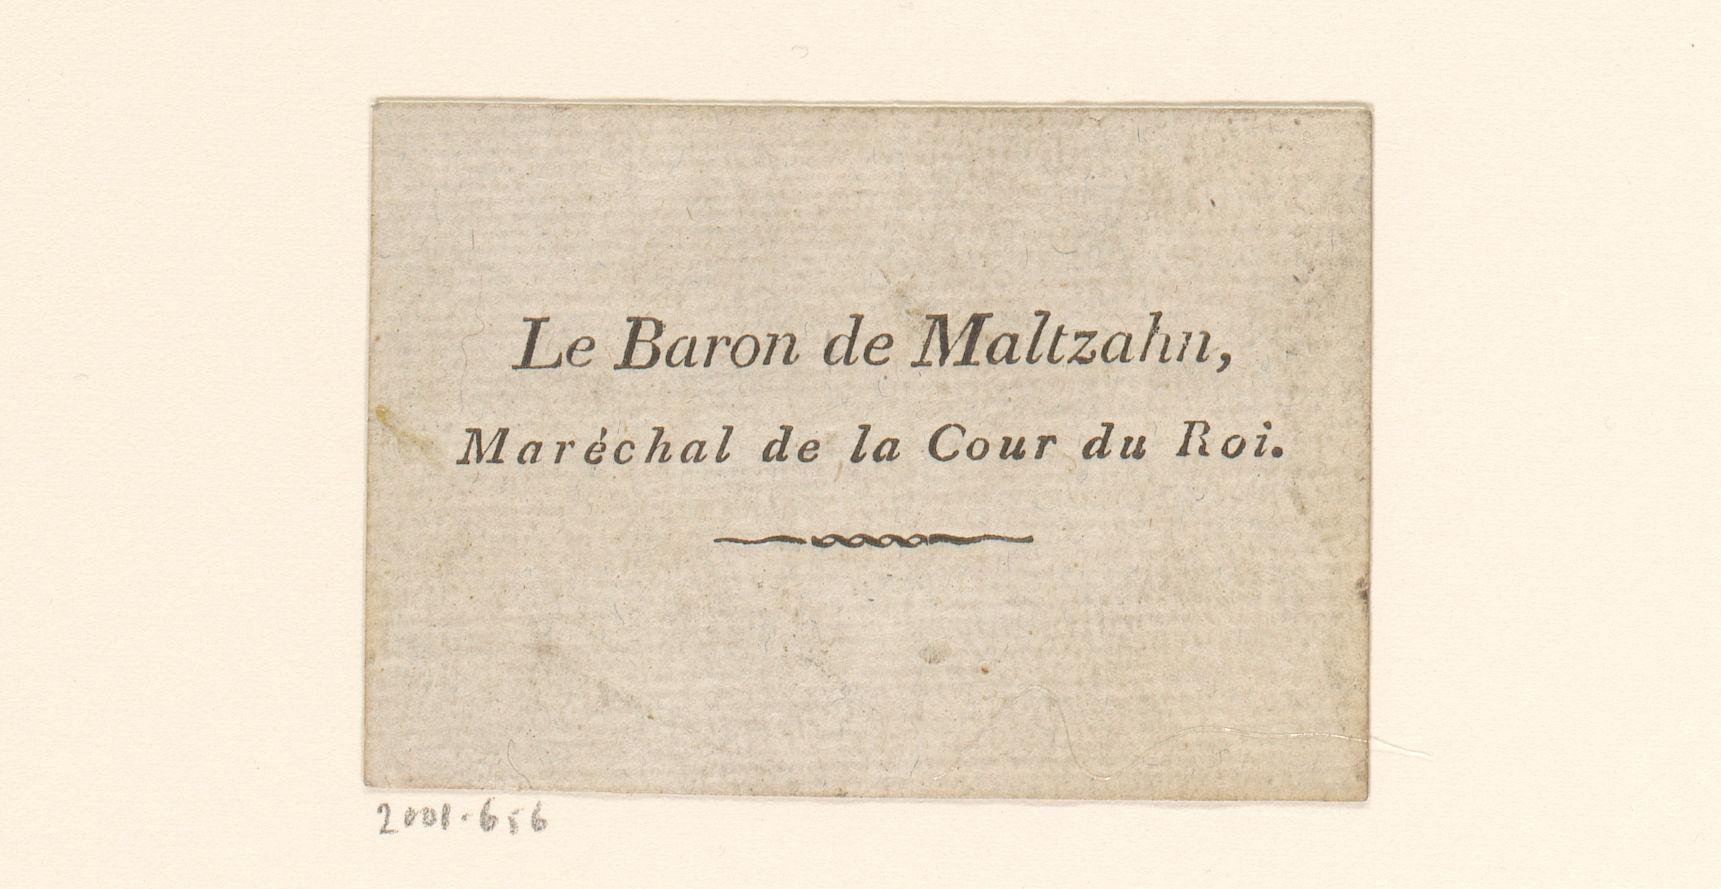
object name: visiting card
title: Visitekaart van Baron Burchard Friedrich van Maltzahn, Maréchal aan het koninklijk hof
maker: Anonymous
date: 1783-1837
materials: paper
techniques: letterpress printing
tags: visiting-card, calling-card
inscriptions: collector's mark: Lugt 2228, collector's mark: Lugt 2760